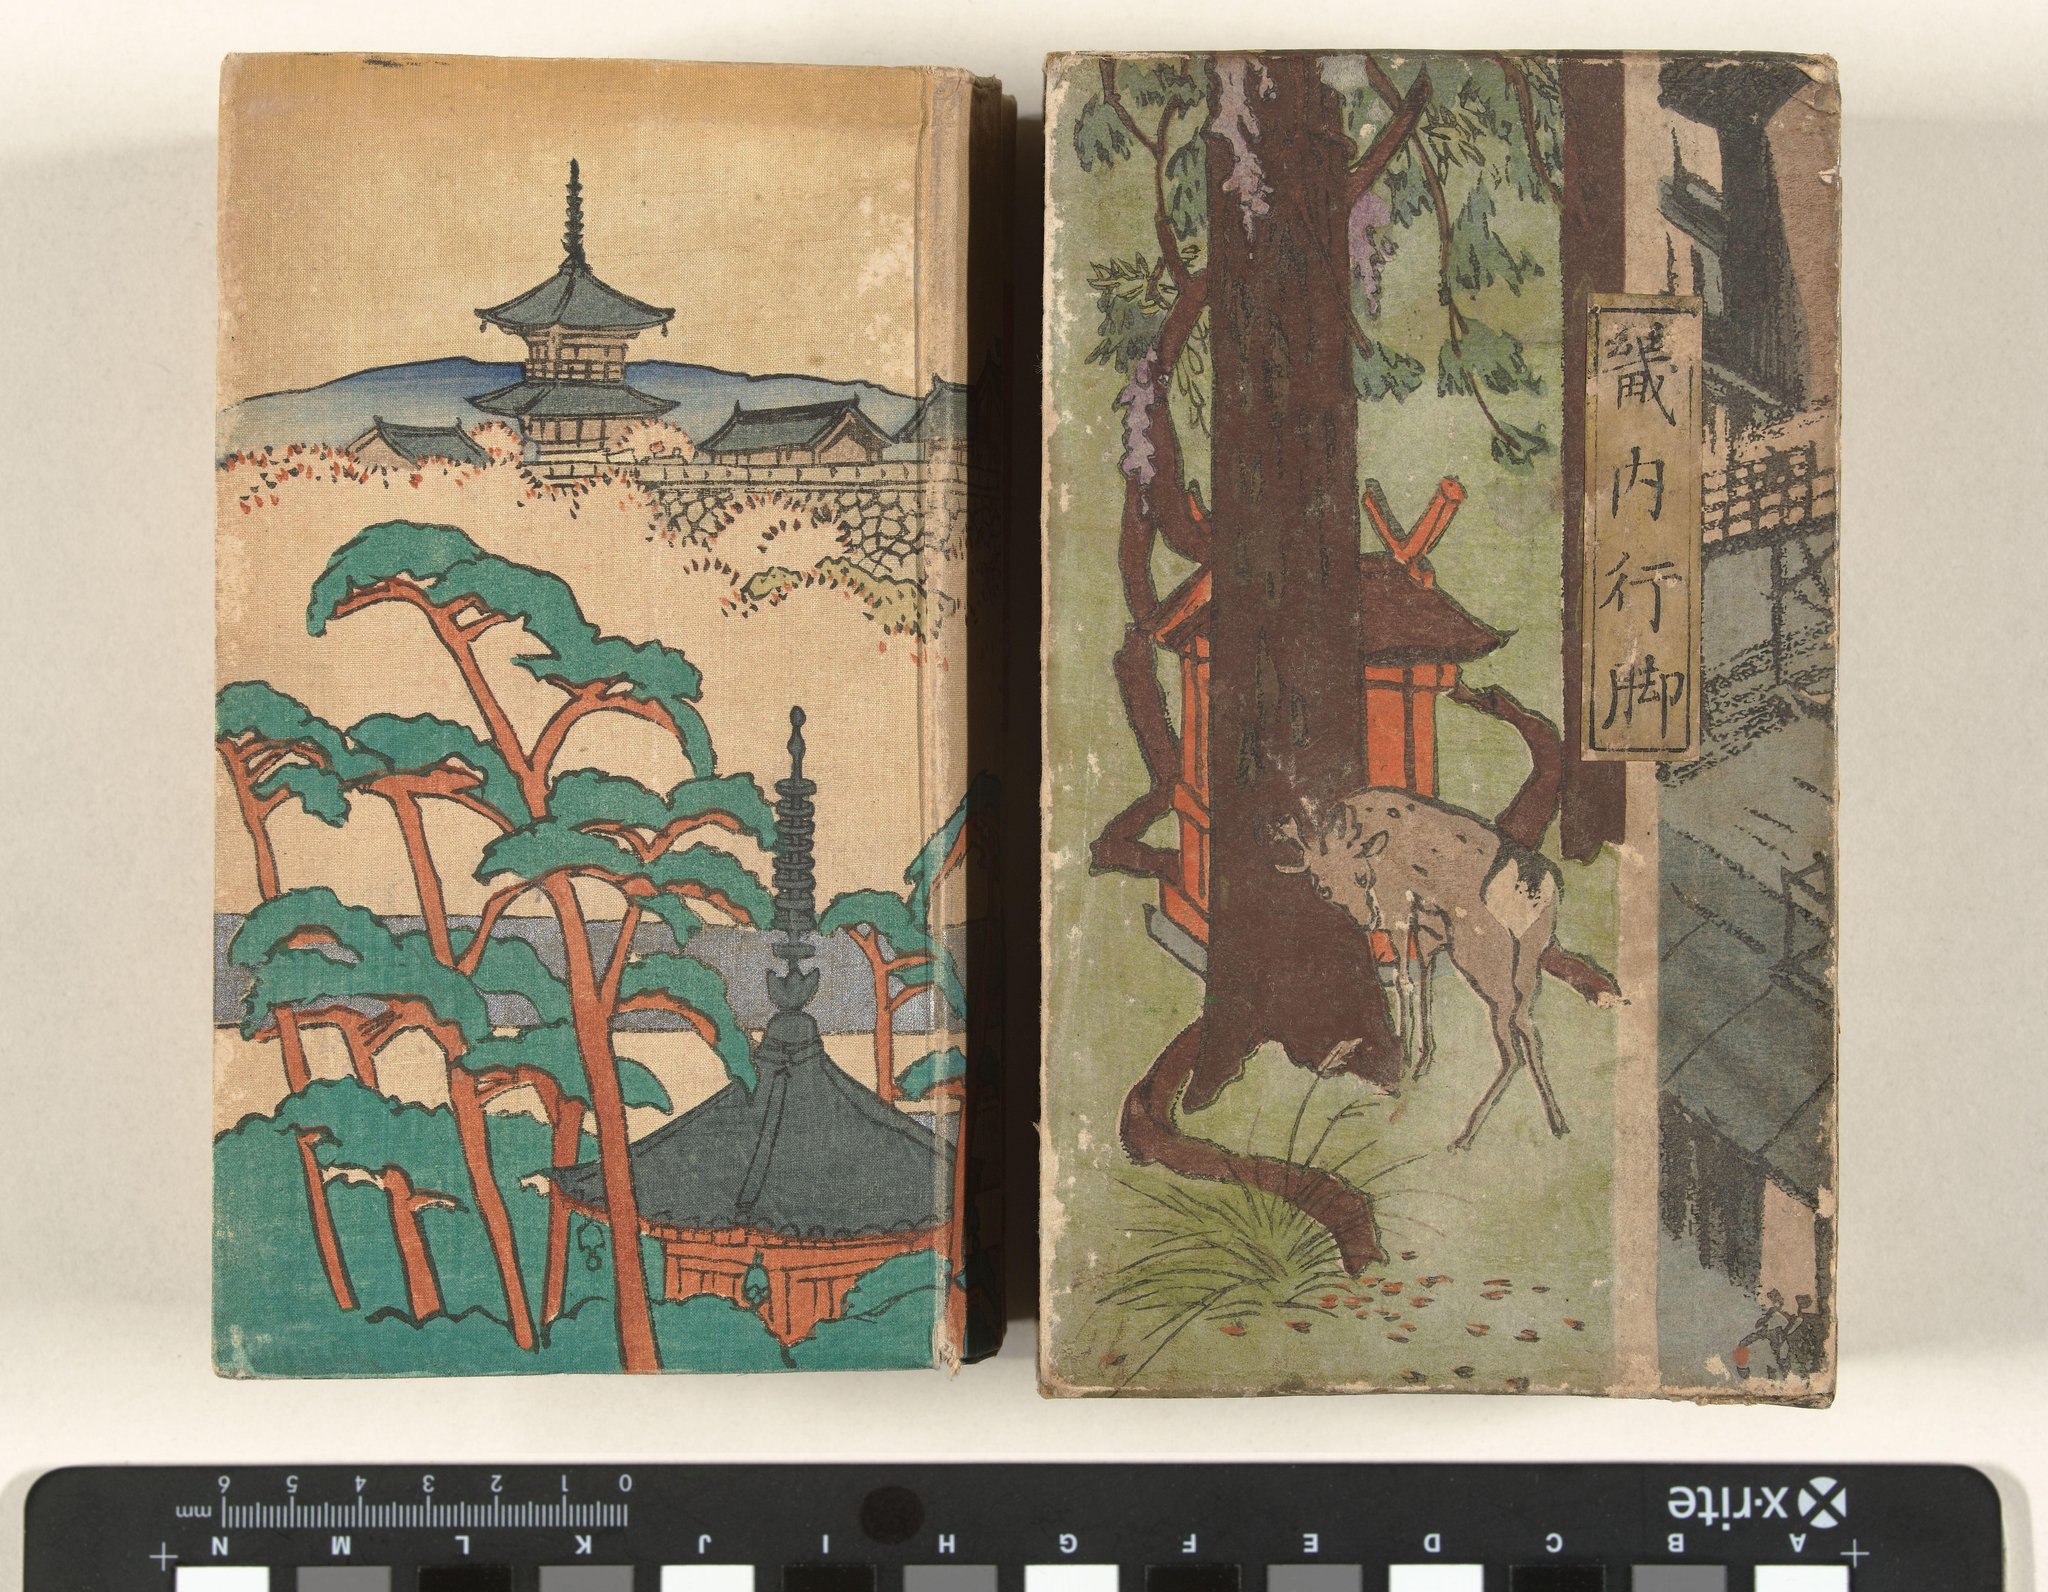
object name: book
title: Kinai angya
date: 1909-1919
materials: paper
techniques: woodcut, letterpress printing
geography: japan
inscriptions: date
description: De Kinai regio is het gebied rond de steden Nara, Osaka, Kyoto en Kobe.